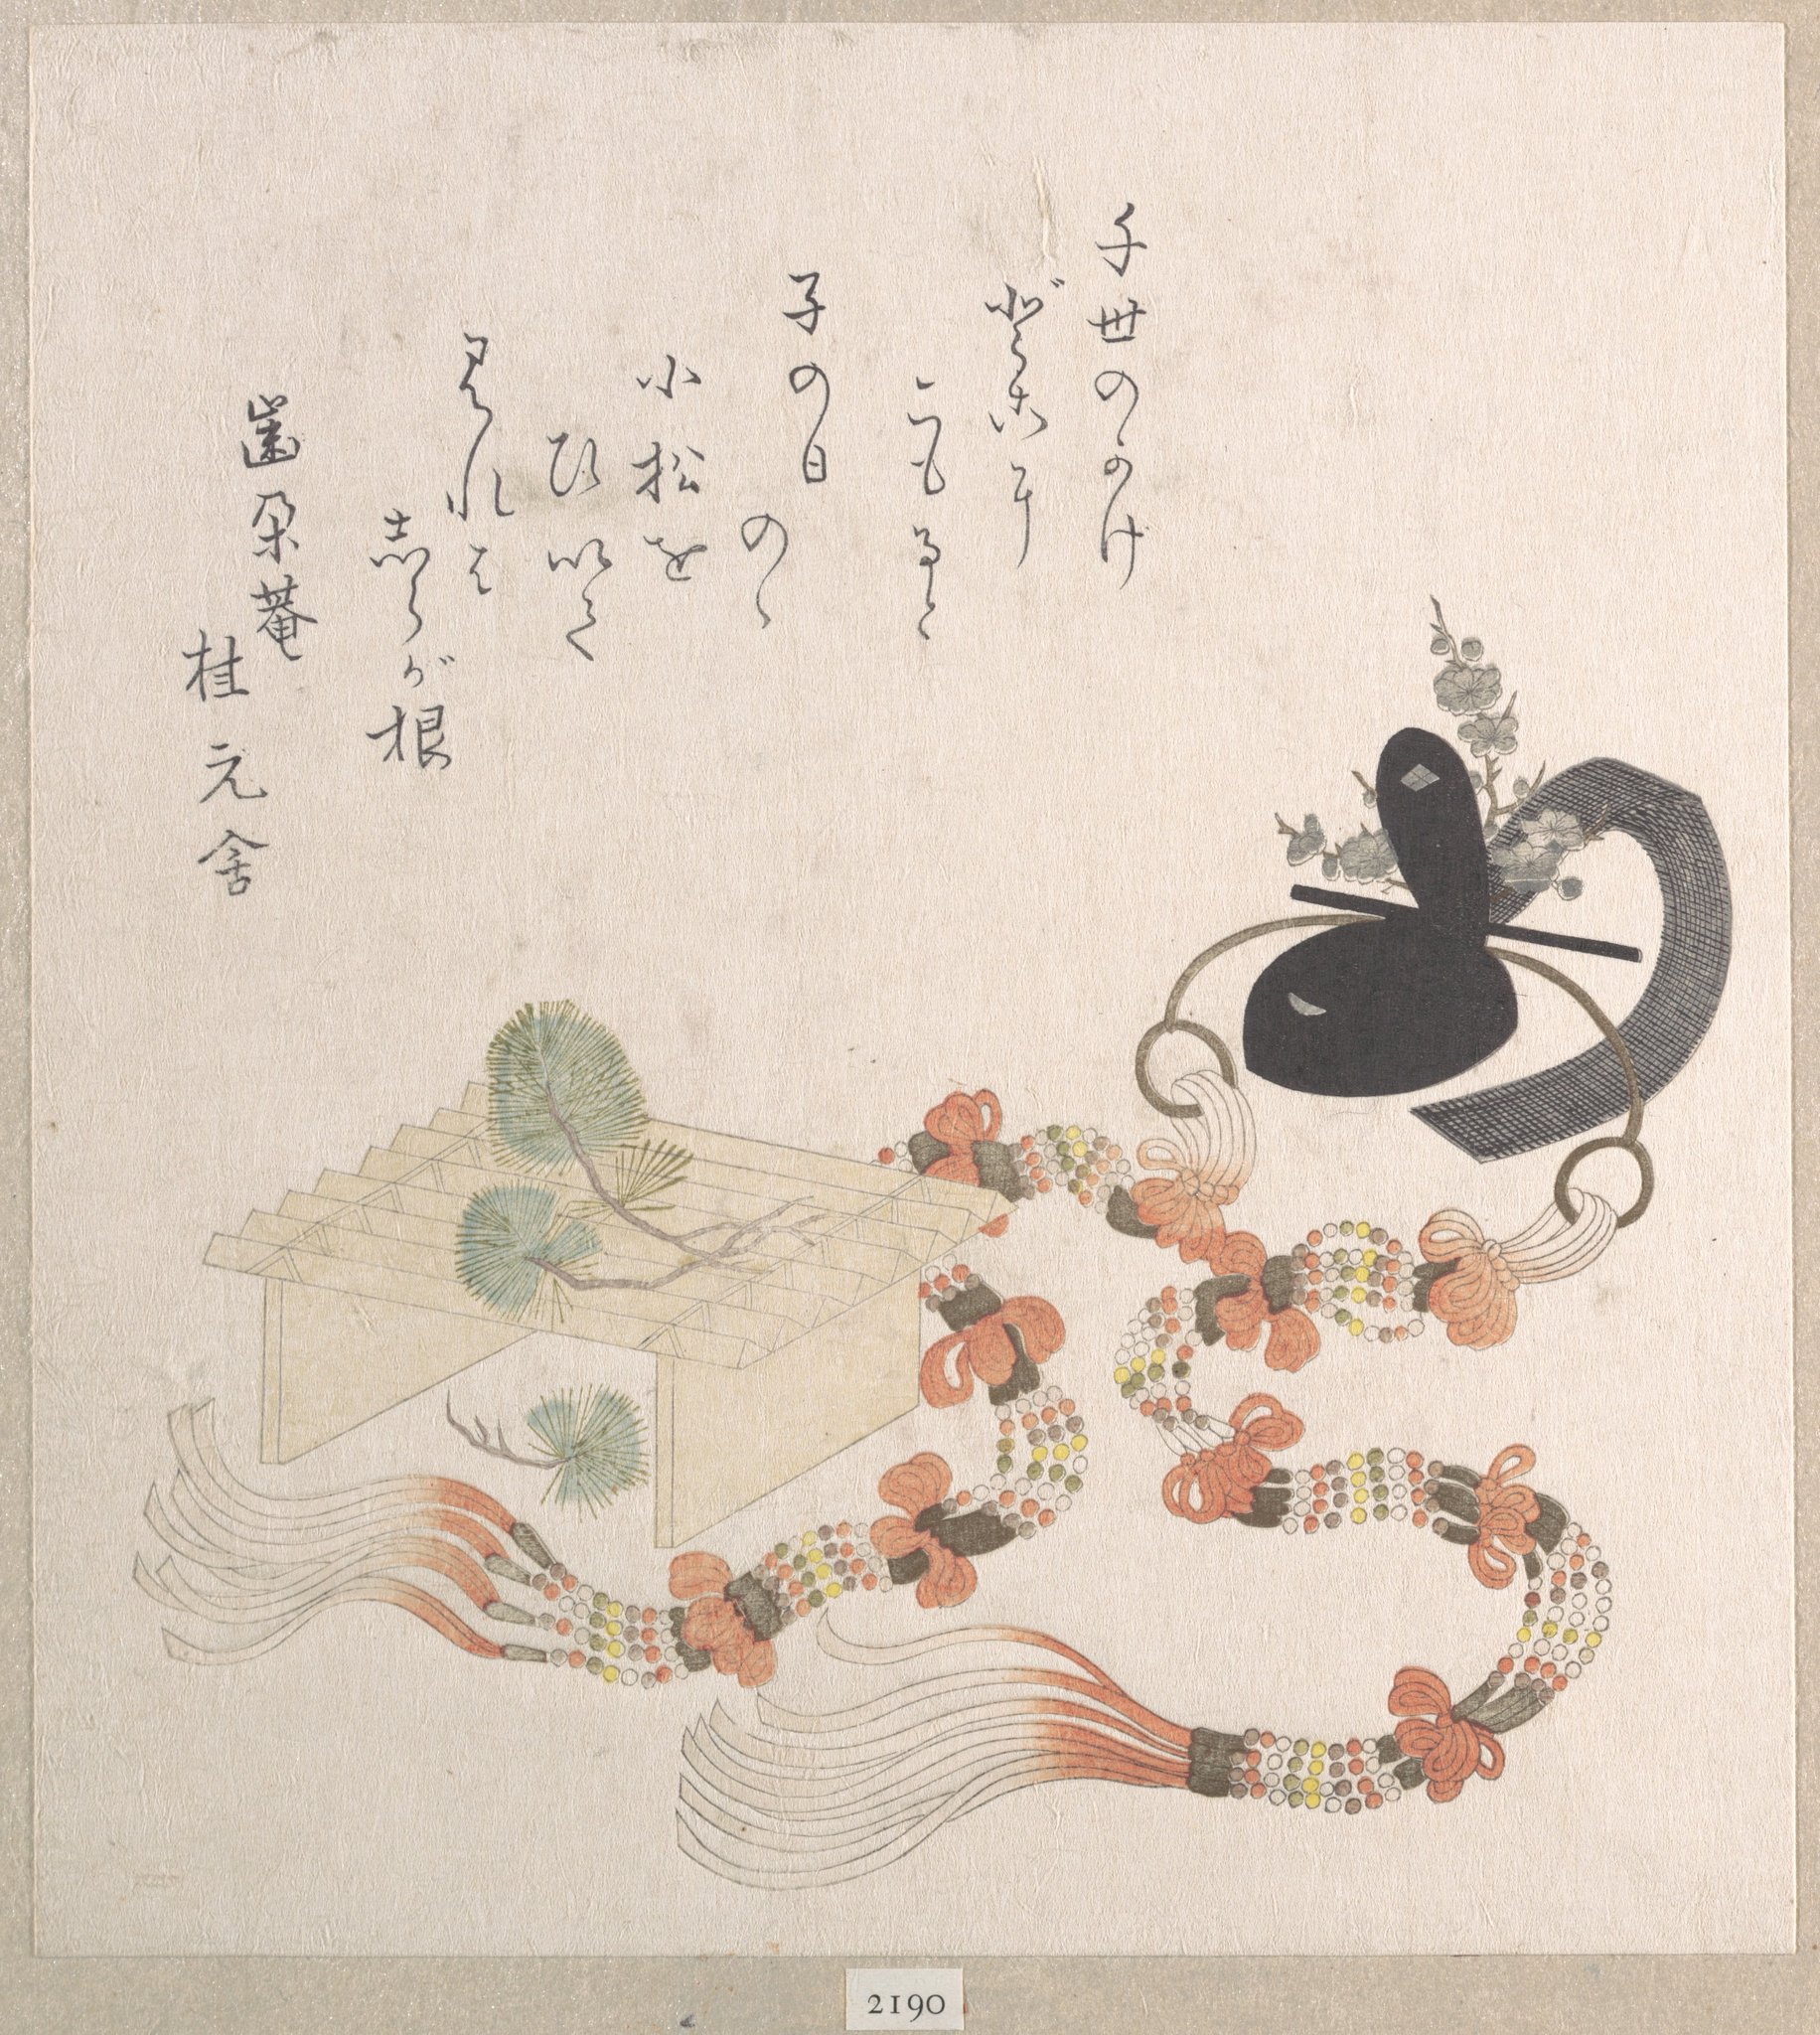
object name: print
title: Young Pine Trees on a Stand and a Ceremonial Crown with Long Hangings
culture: japanese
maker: unidentified artist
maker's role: artist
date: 1701-1900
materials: ink, paper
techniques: surimono, woodblock print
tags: crowns